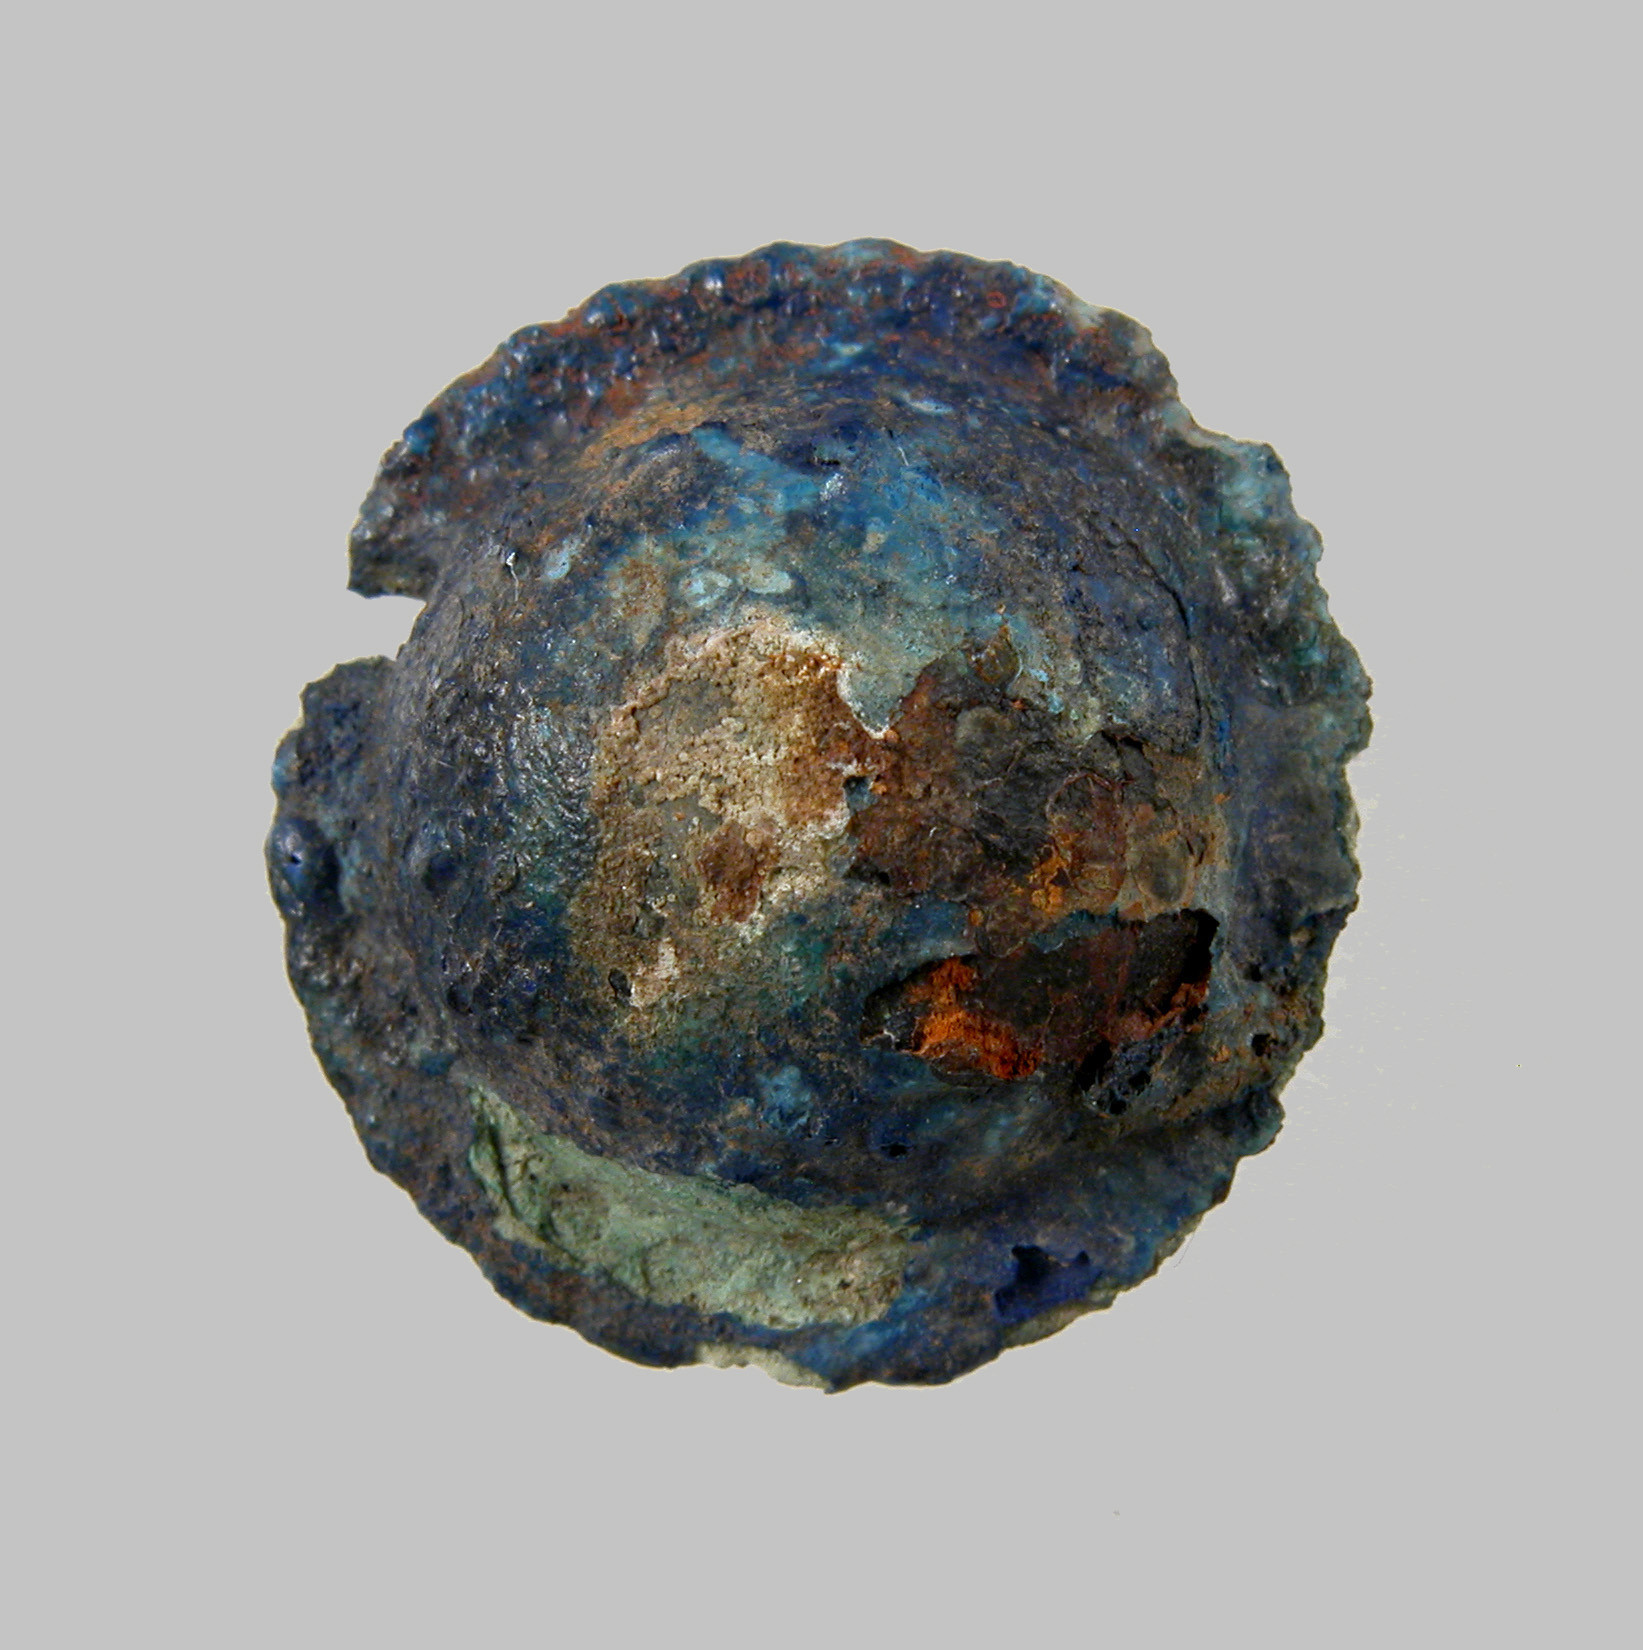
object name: bos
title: Small Hollow Boss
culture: frankish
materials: copper alloy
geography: germany